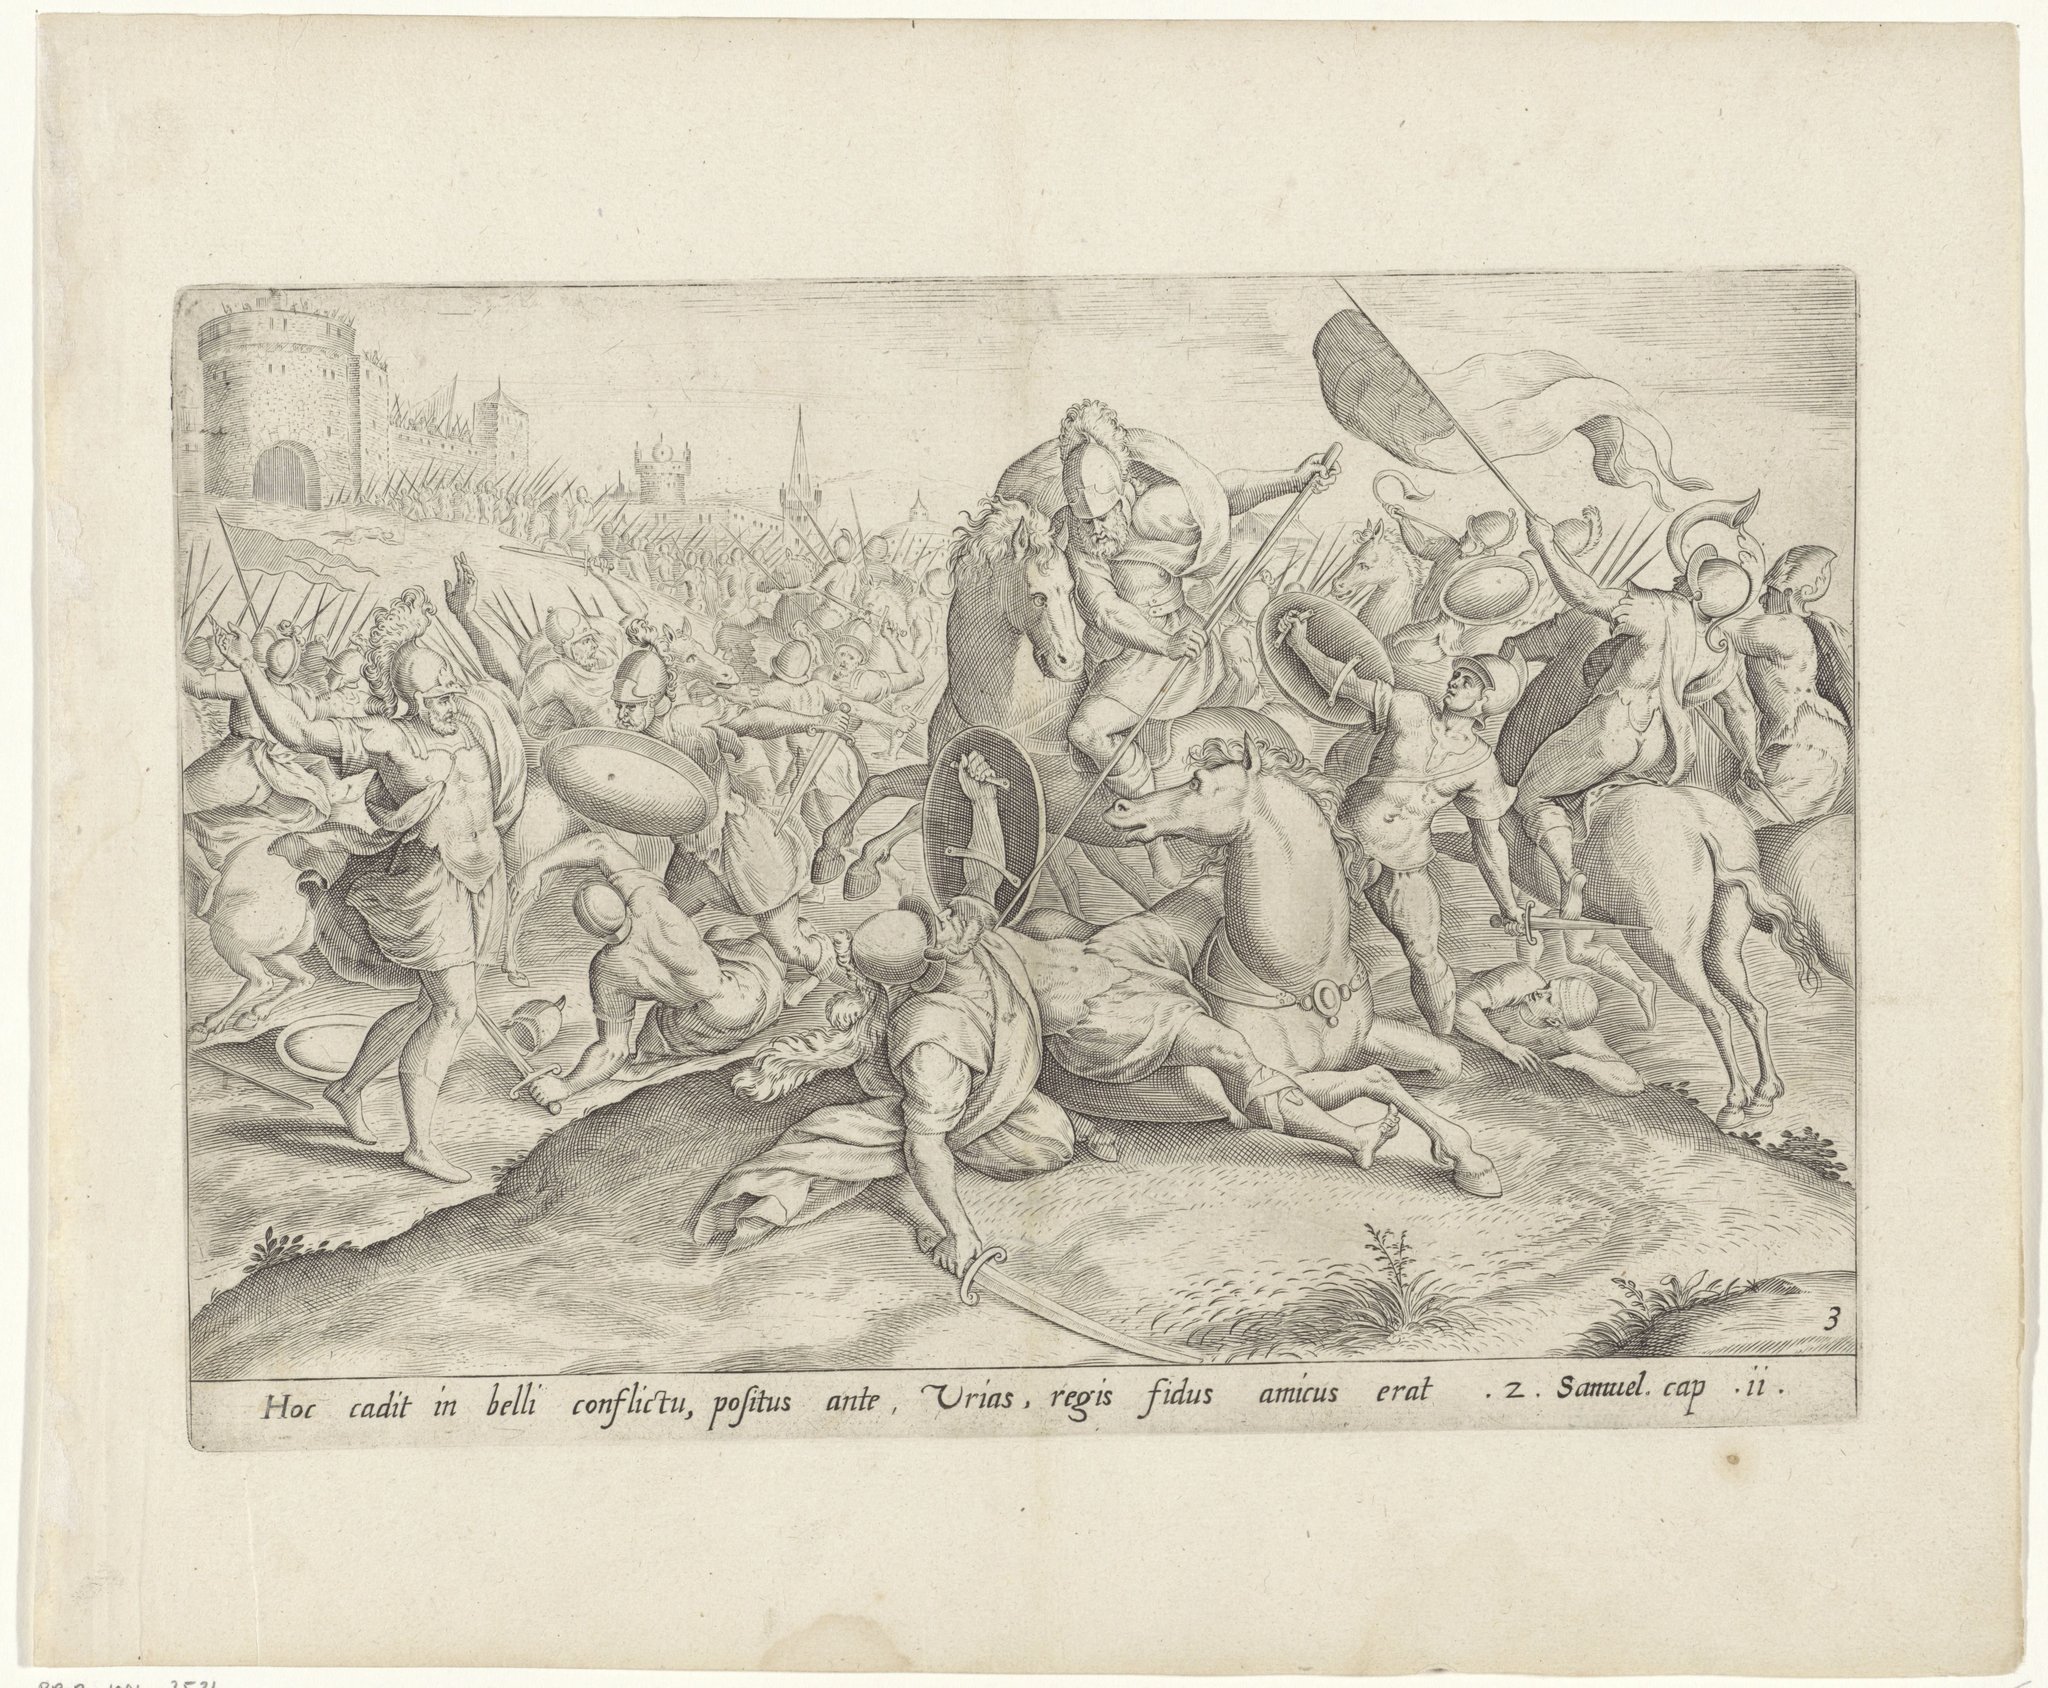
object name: print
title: Dood van Uria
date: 1579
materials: paper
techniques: engraving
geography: amsterdam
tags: uriah is killed in the battle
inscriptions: collector's mark: Lugt 2228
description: Latere staat van prent gebruikt in: Theatrum biblicum : hoc est historiae sacrae veteris et novi testamenti tabulis aeneis expressae. Opus praesentatissimorum huius ac superioris seculi pictorum atque sculptorum, summo studio conquisitum et in lucem editum. Amsterdam: Claes Jansz. Visscher, 1643.